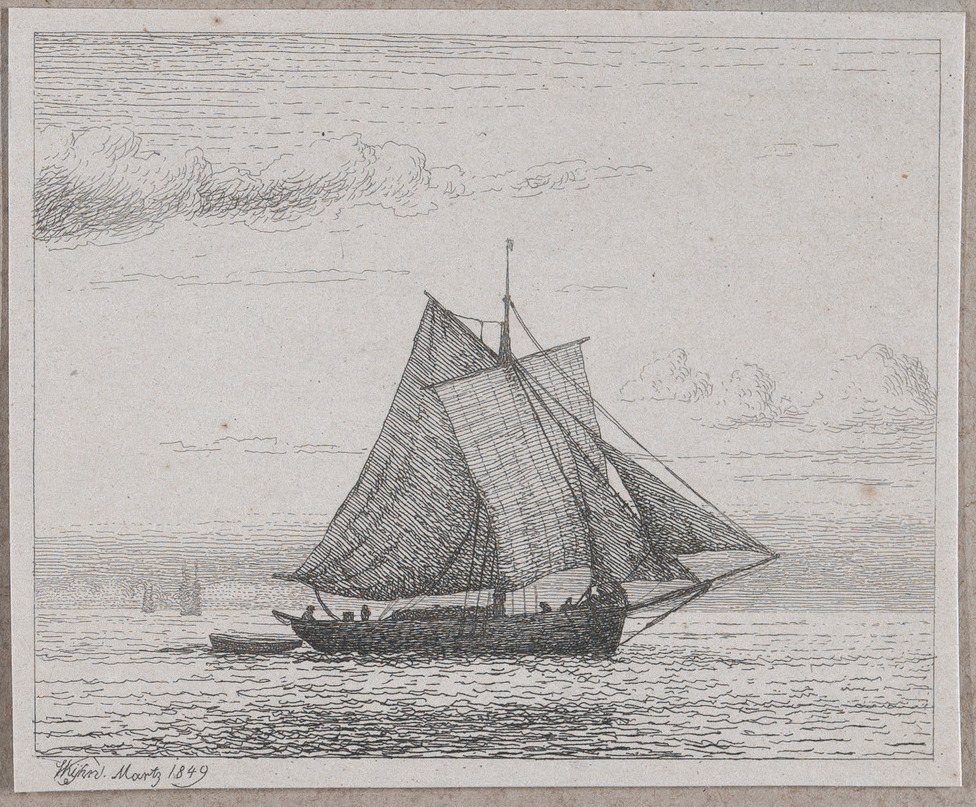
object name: print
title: Maritime View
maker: peter vilhelm carl kyhn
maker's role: artist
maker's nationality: danish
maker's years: 1819-1903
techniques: etching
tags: boats